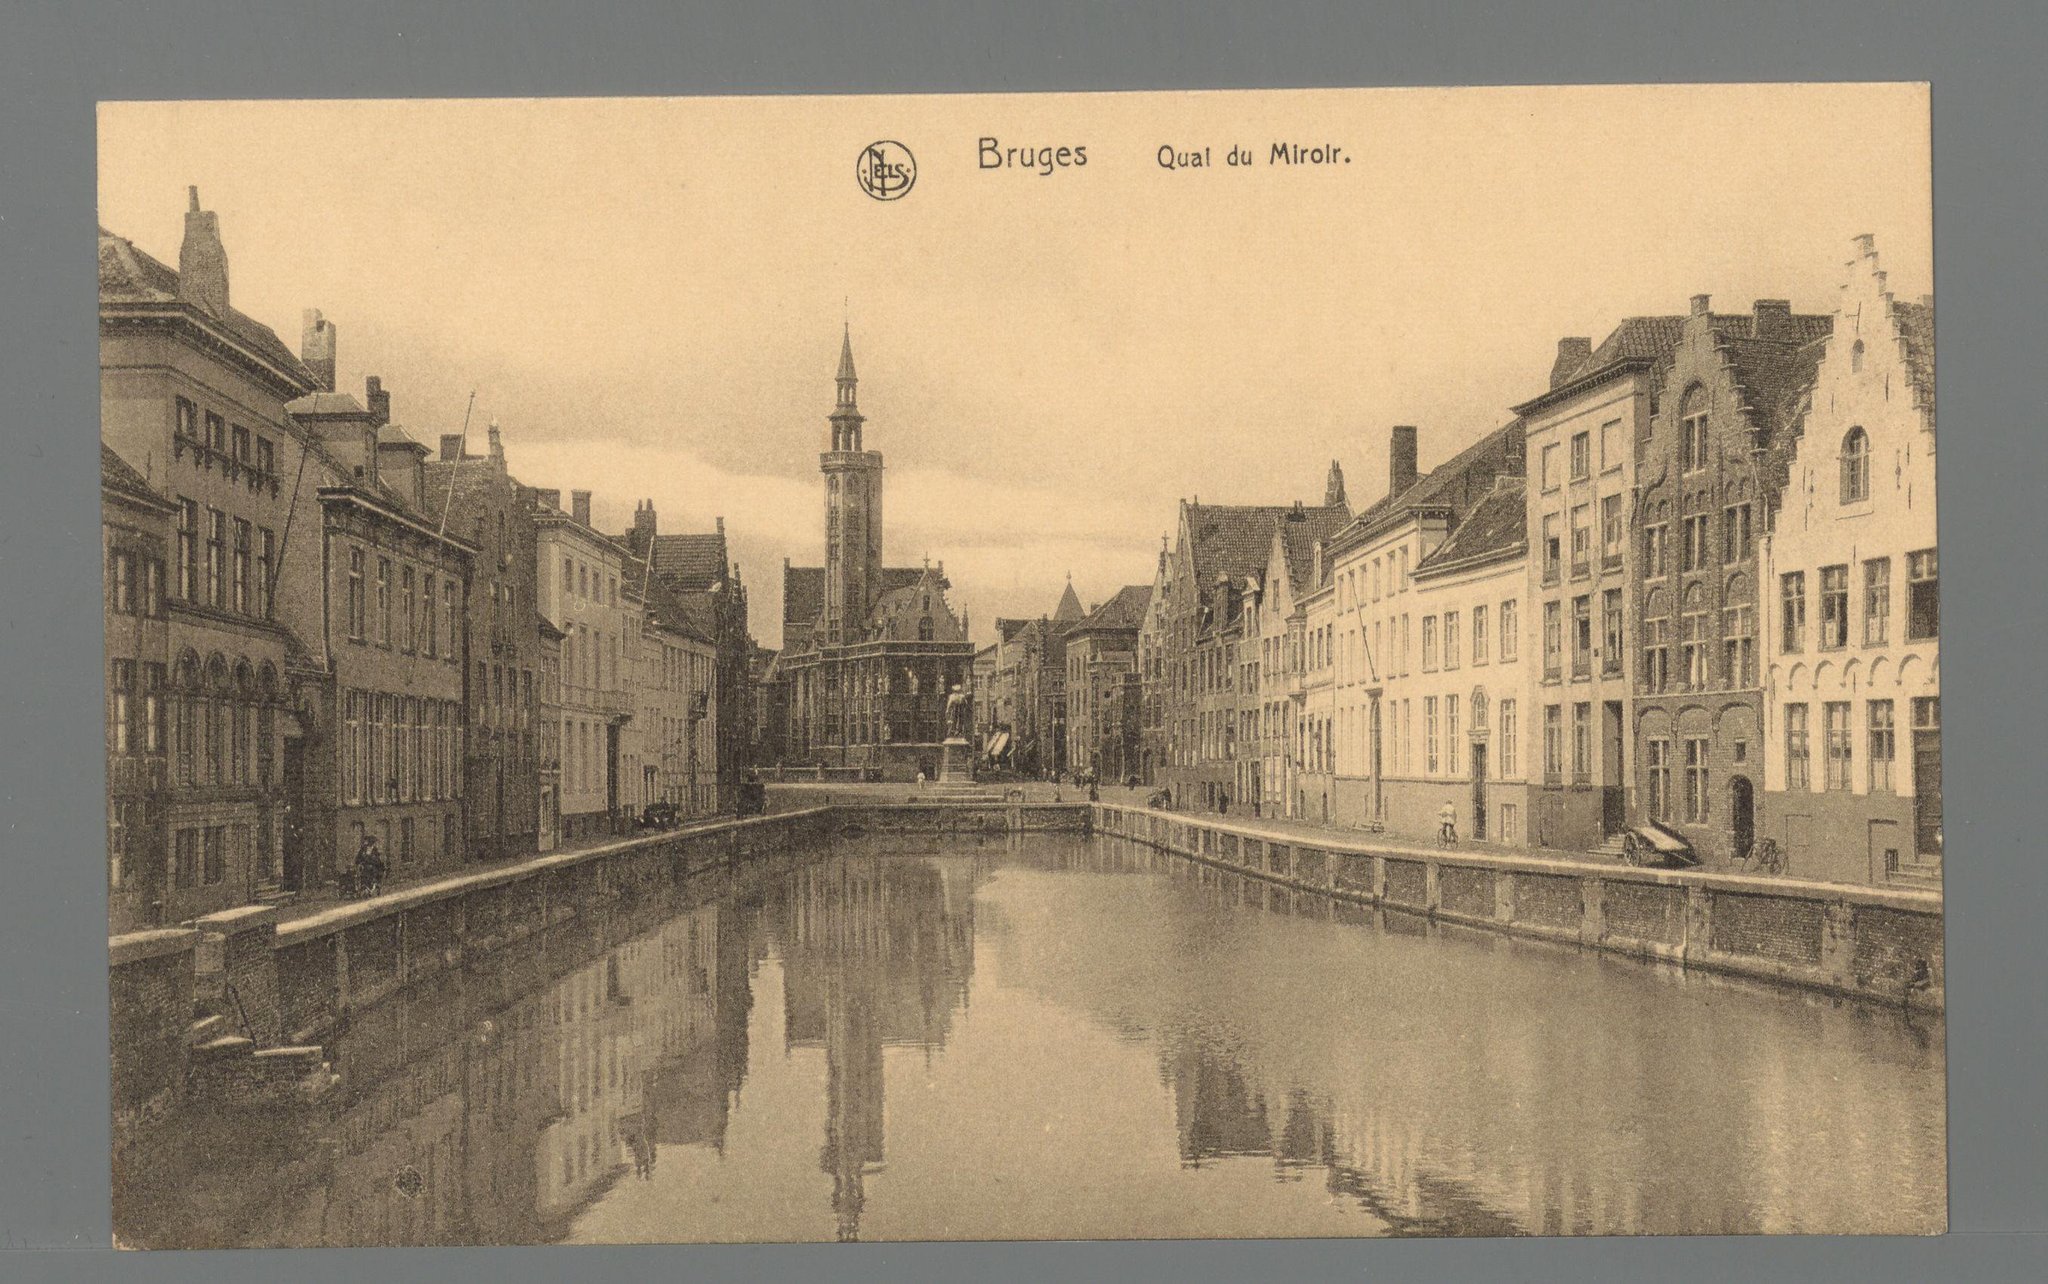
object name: photomechanical print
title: Série 12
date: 1913-1930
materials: cardboard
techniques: photograph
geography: brussels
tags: urban housing, canal, church (exterior), bruges